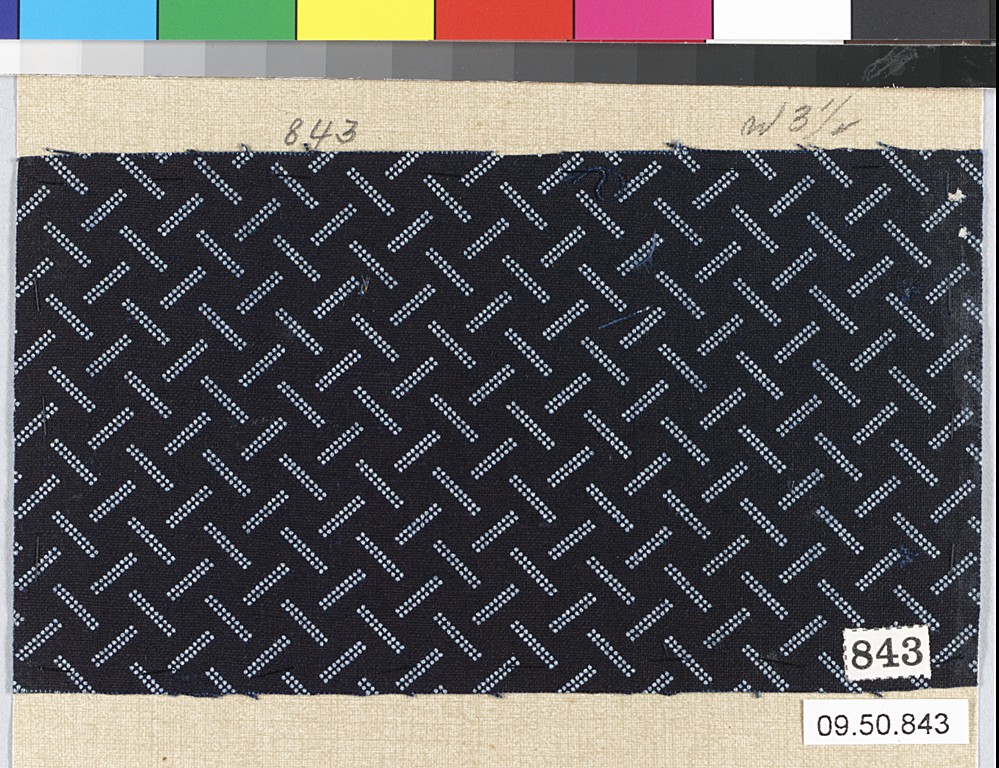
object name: piece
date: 1801-1900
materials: cotton